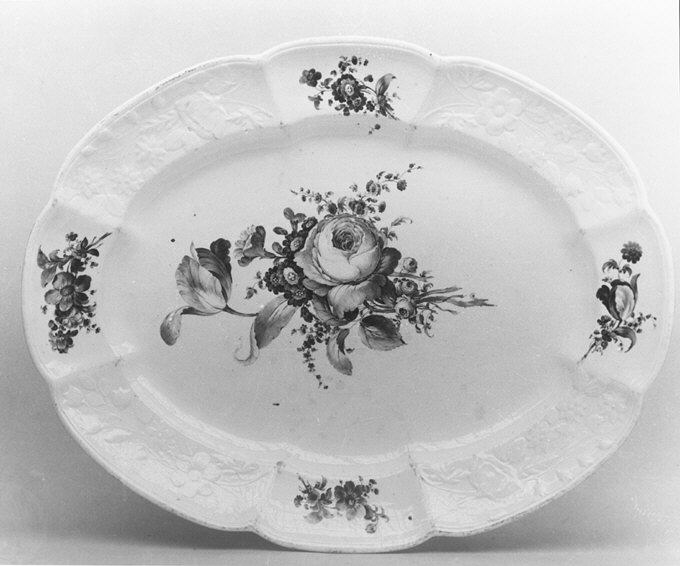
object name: platter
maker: höchst manufactory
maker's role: manufactory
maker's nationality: german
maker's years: 1746-1796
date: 1765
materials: hard paste porcelain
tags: roses